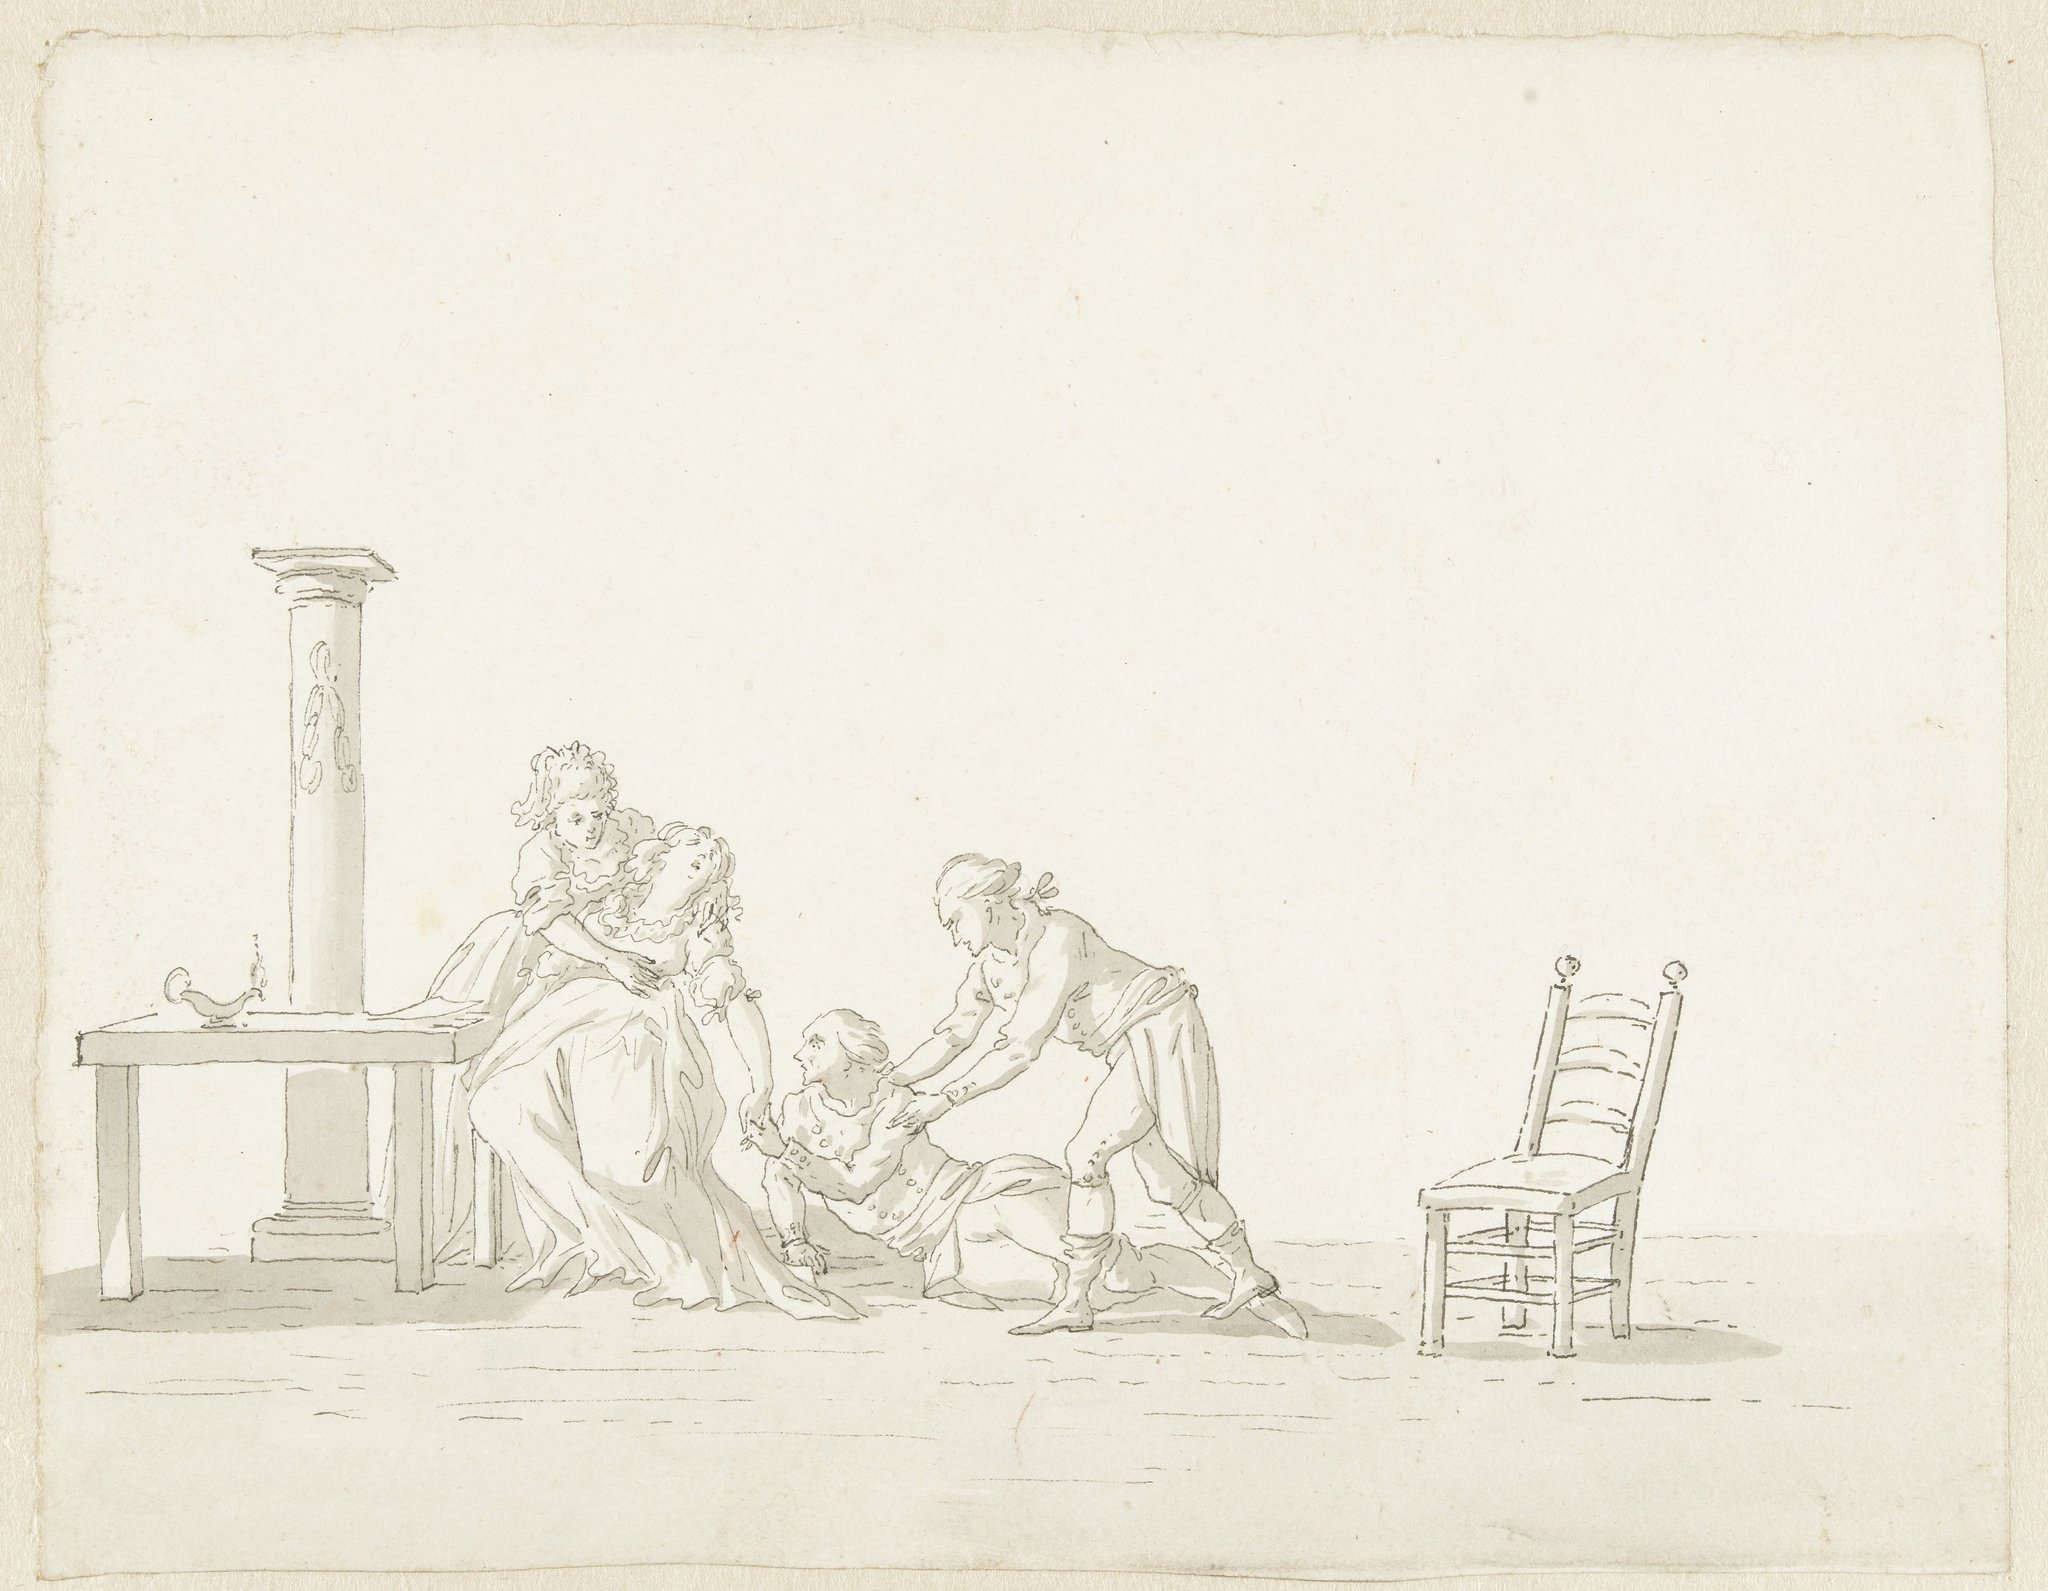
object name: drawing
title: Een vrouw bezwijmt na het lezen van een brief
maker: pieter bartholomeusz. barbiers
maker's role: draughtsman, print maker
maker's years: 1772-1837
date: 1782-1837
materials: ink, paper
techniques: brush, pen